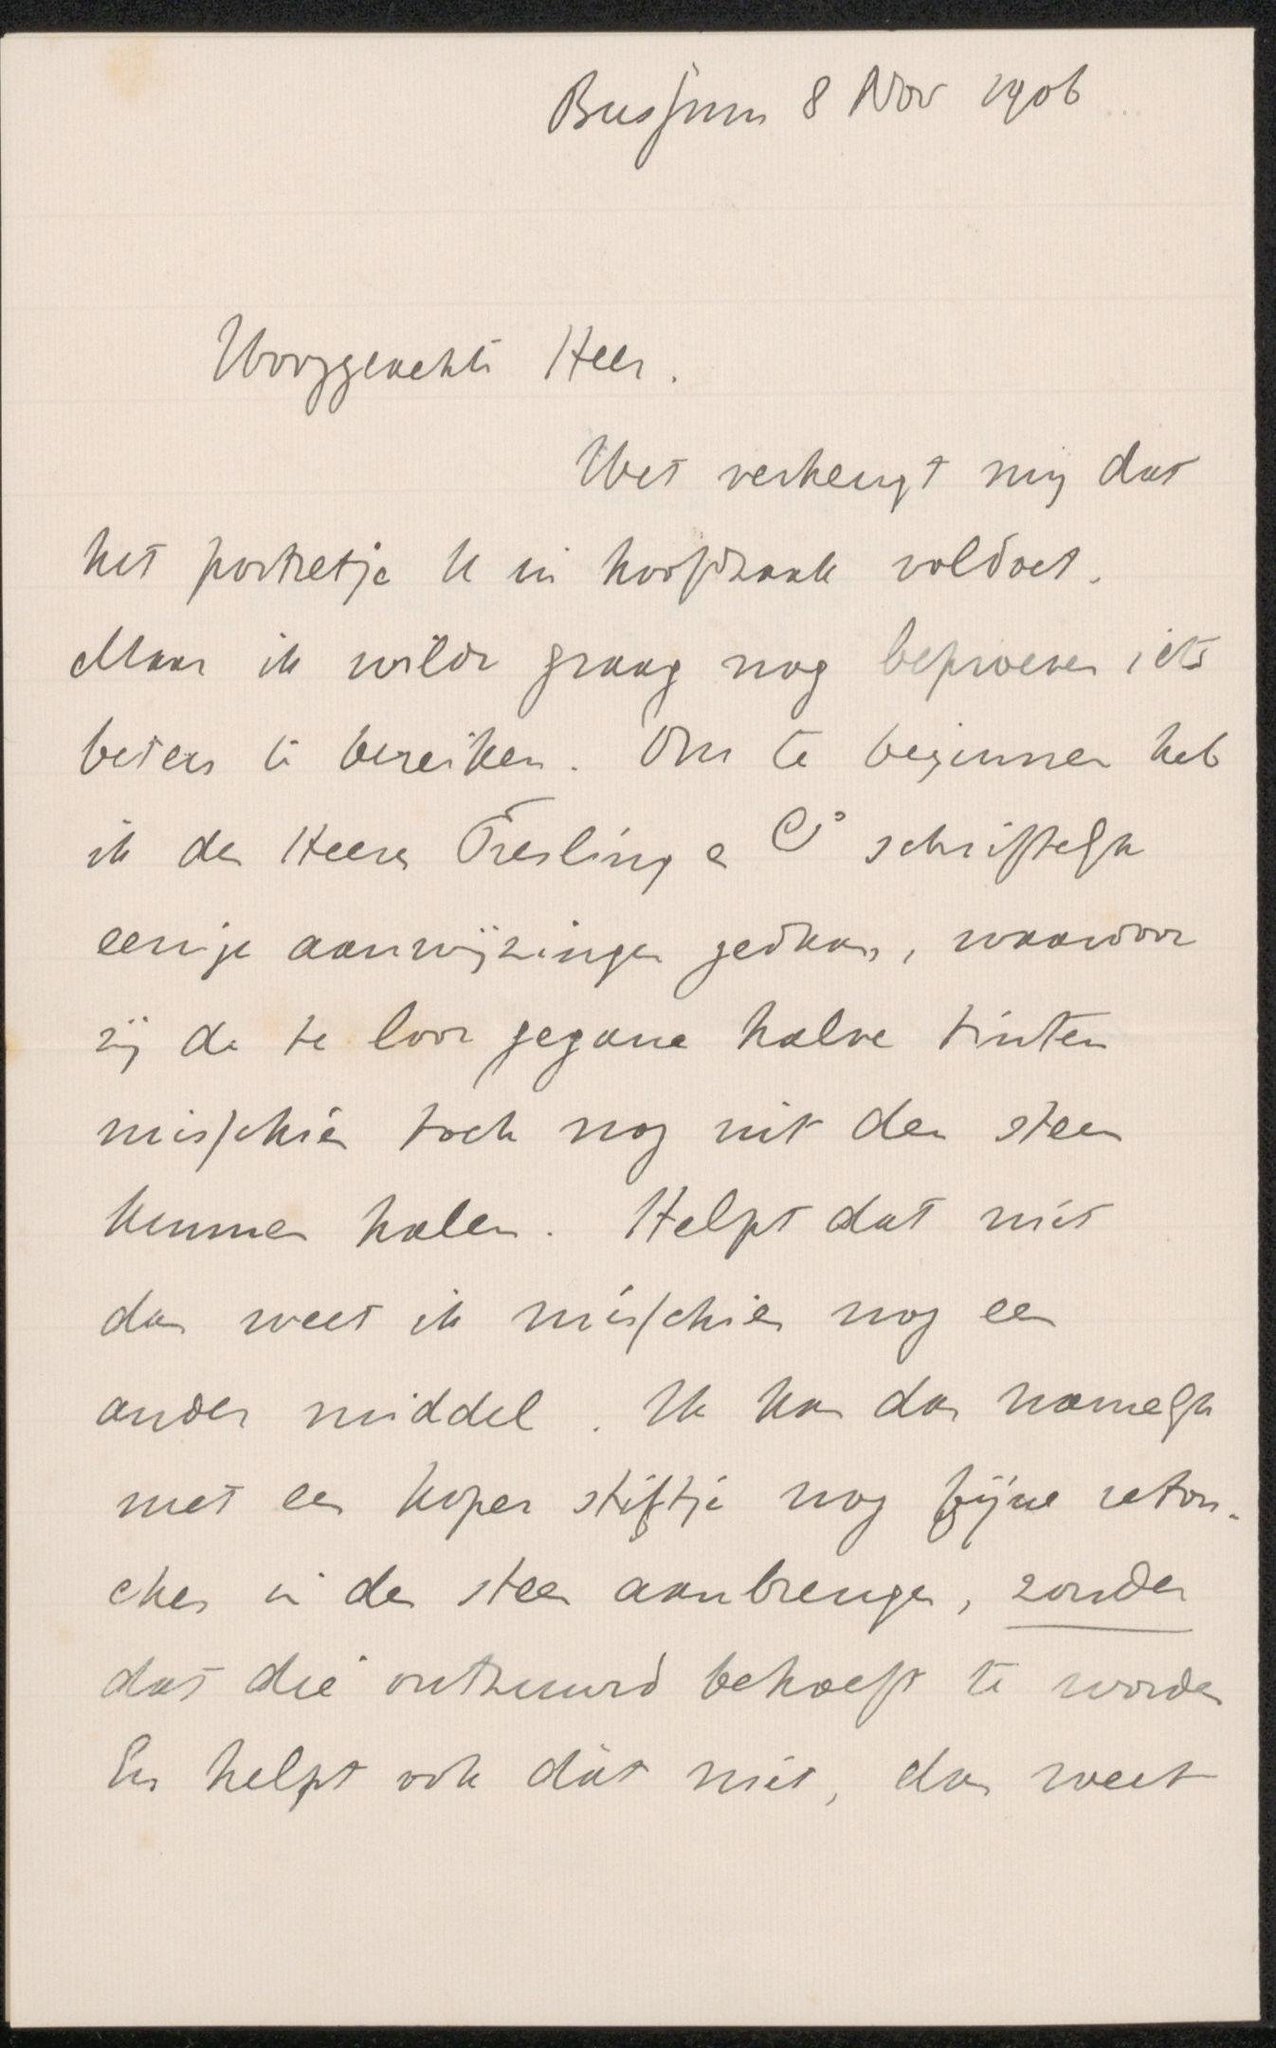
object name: letter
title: Brief aan Diederik Johannes Korteweg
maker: jan veth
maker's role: designer, draughtsman, painter, print maker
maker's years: 1864-1925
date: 1906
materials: ink, paper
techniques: pen, writing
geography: bussum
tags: publisher, the graphic arts, historical persons (portraits and scenes from the life)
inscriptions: watermark, collector's mark: ‘RPK’